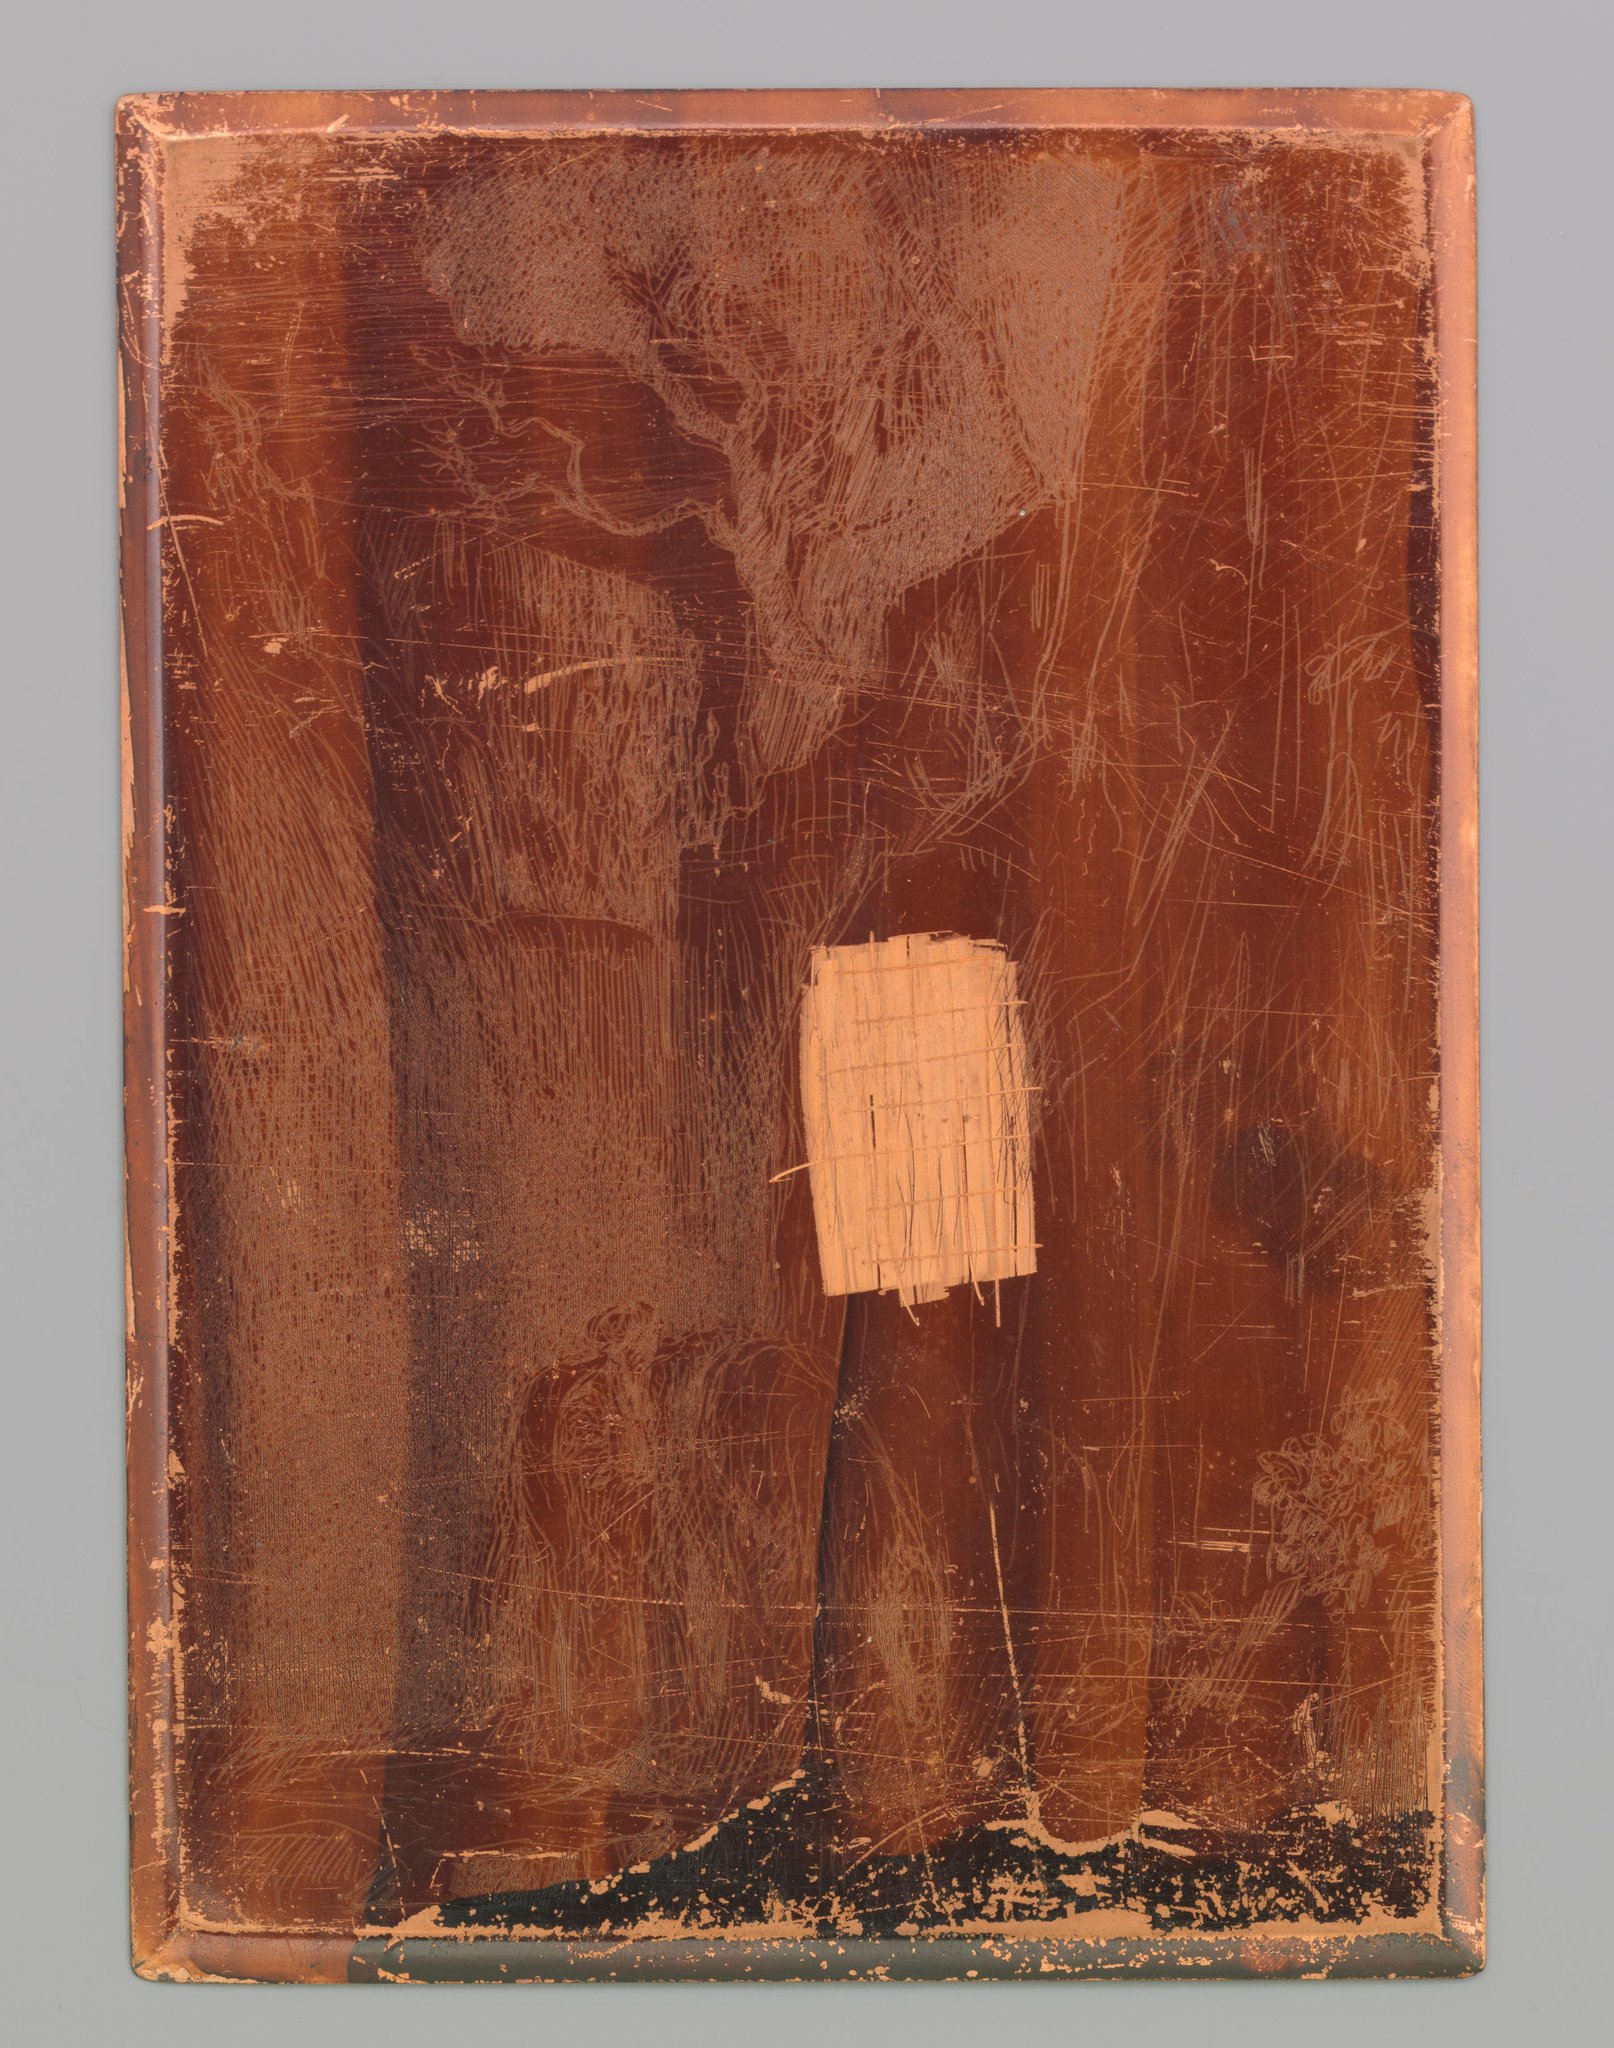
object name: copper plate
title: Aan de bron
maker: marius bauer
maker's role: draughtsman, print maker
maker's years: 1867-1932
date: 1932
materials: copper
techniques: etching